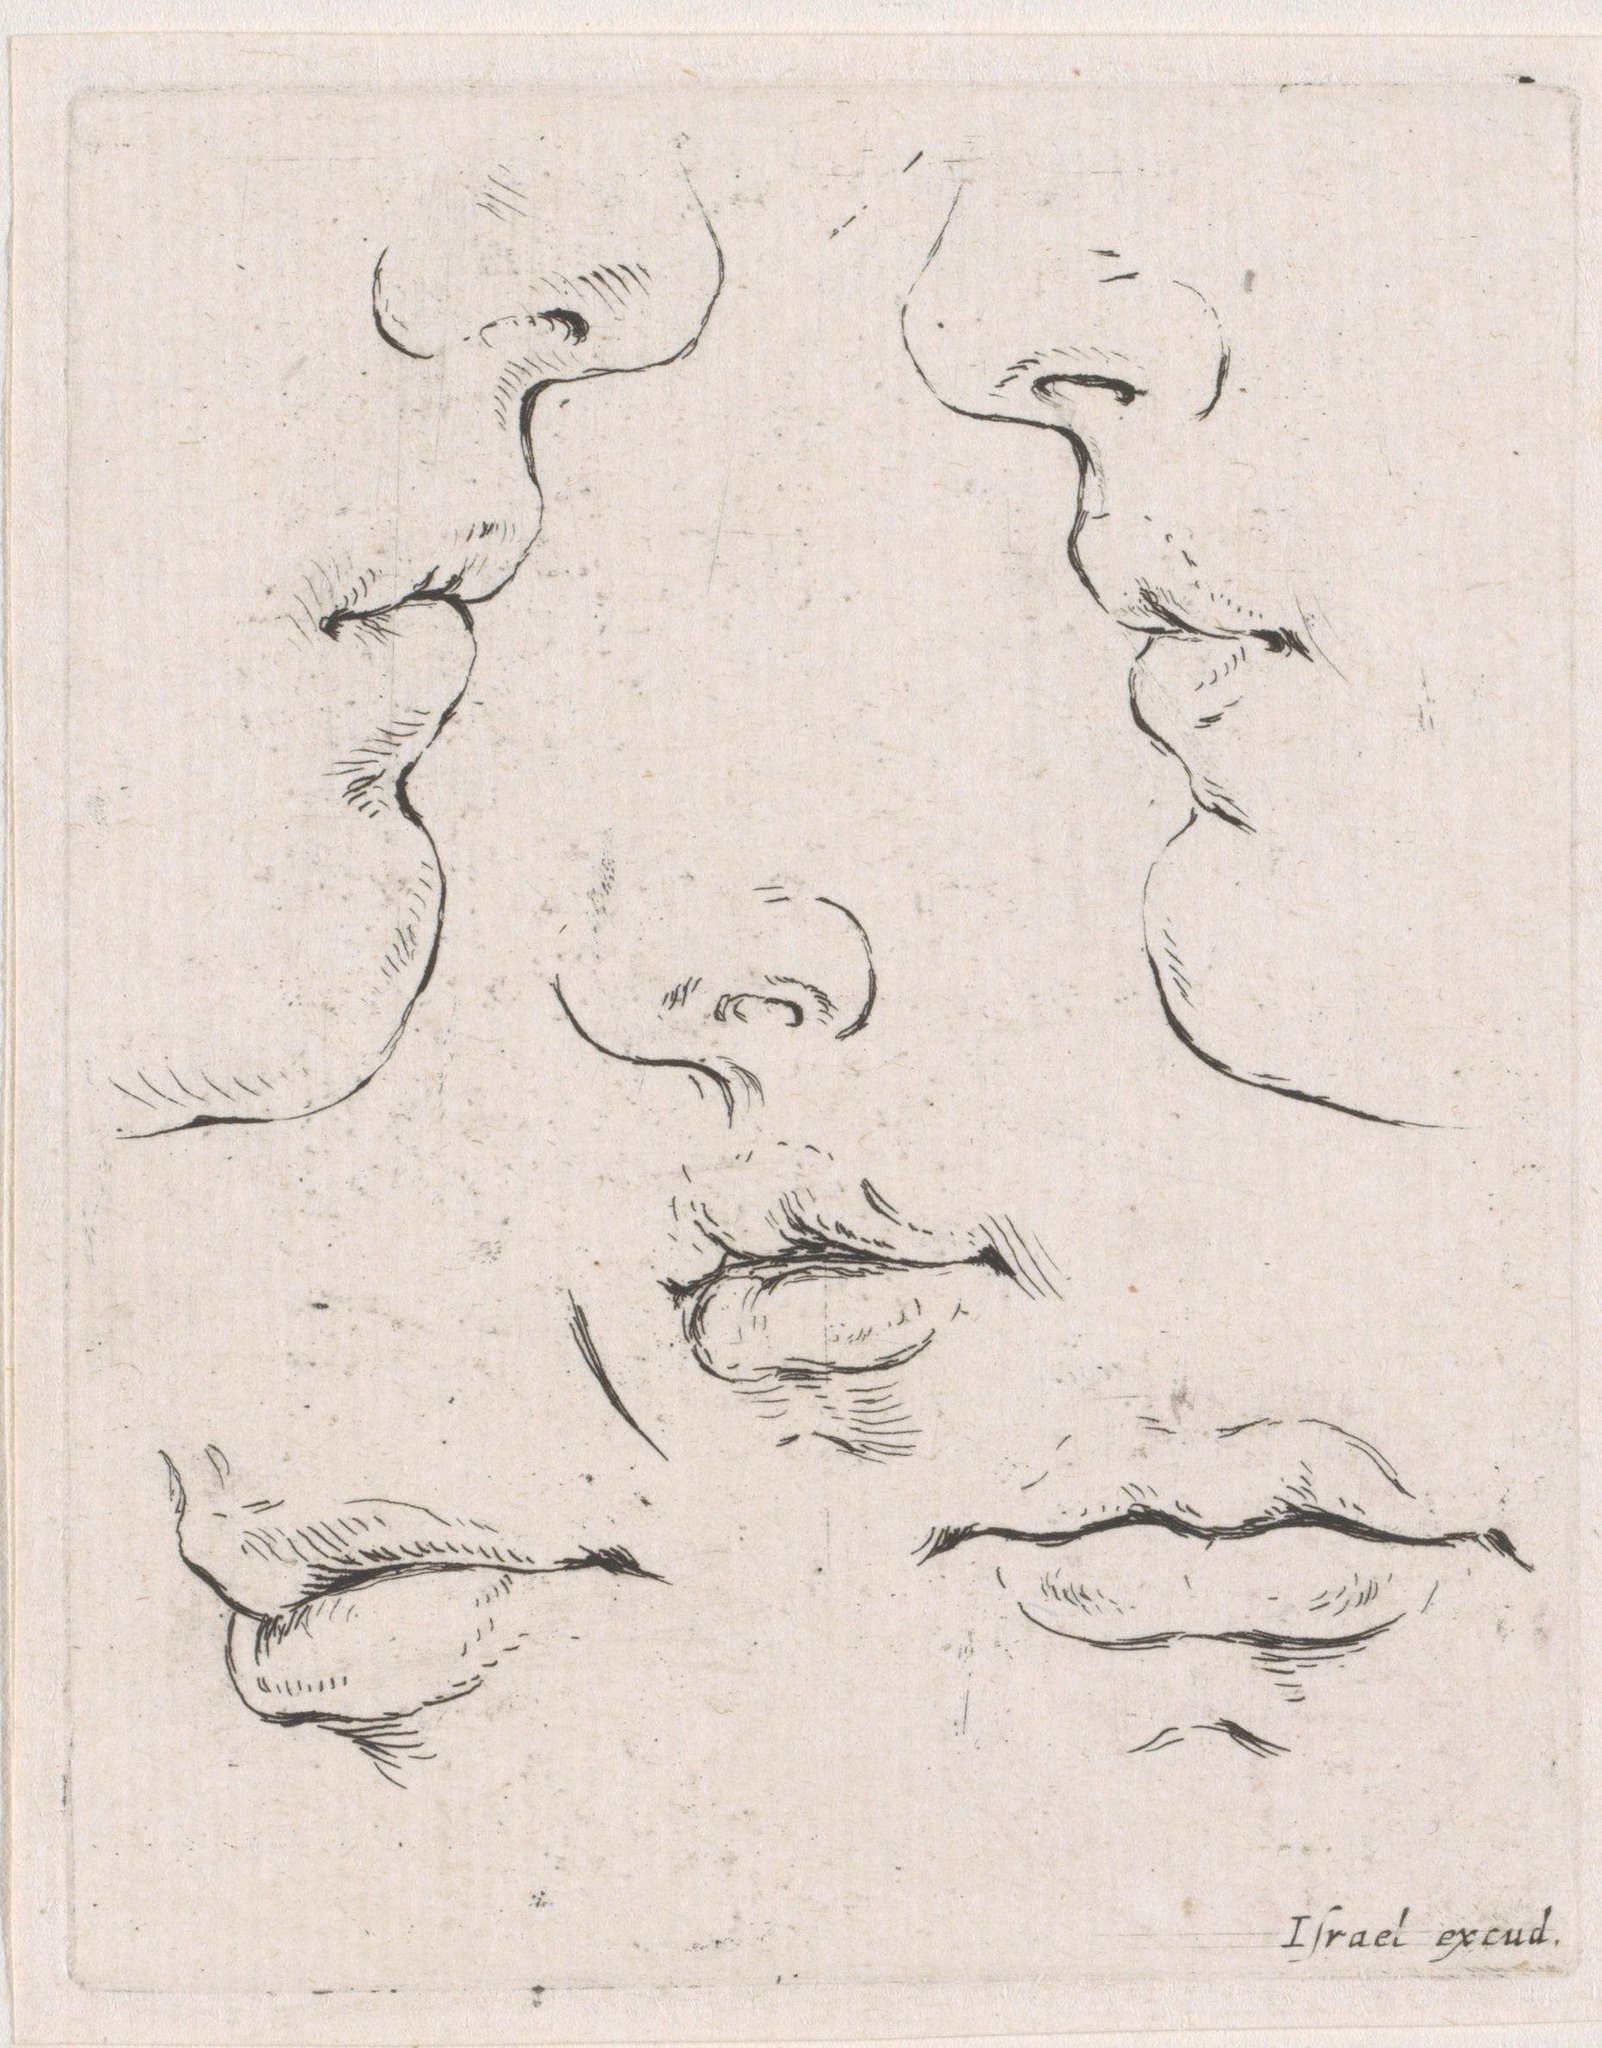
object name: print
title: Livre pour apprendre à dessiner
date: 1620-1664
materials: paper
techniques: etching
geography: paris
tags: parts of the face: nose, mouth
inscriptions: collector's mark: Lugt 240